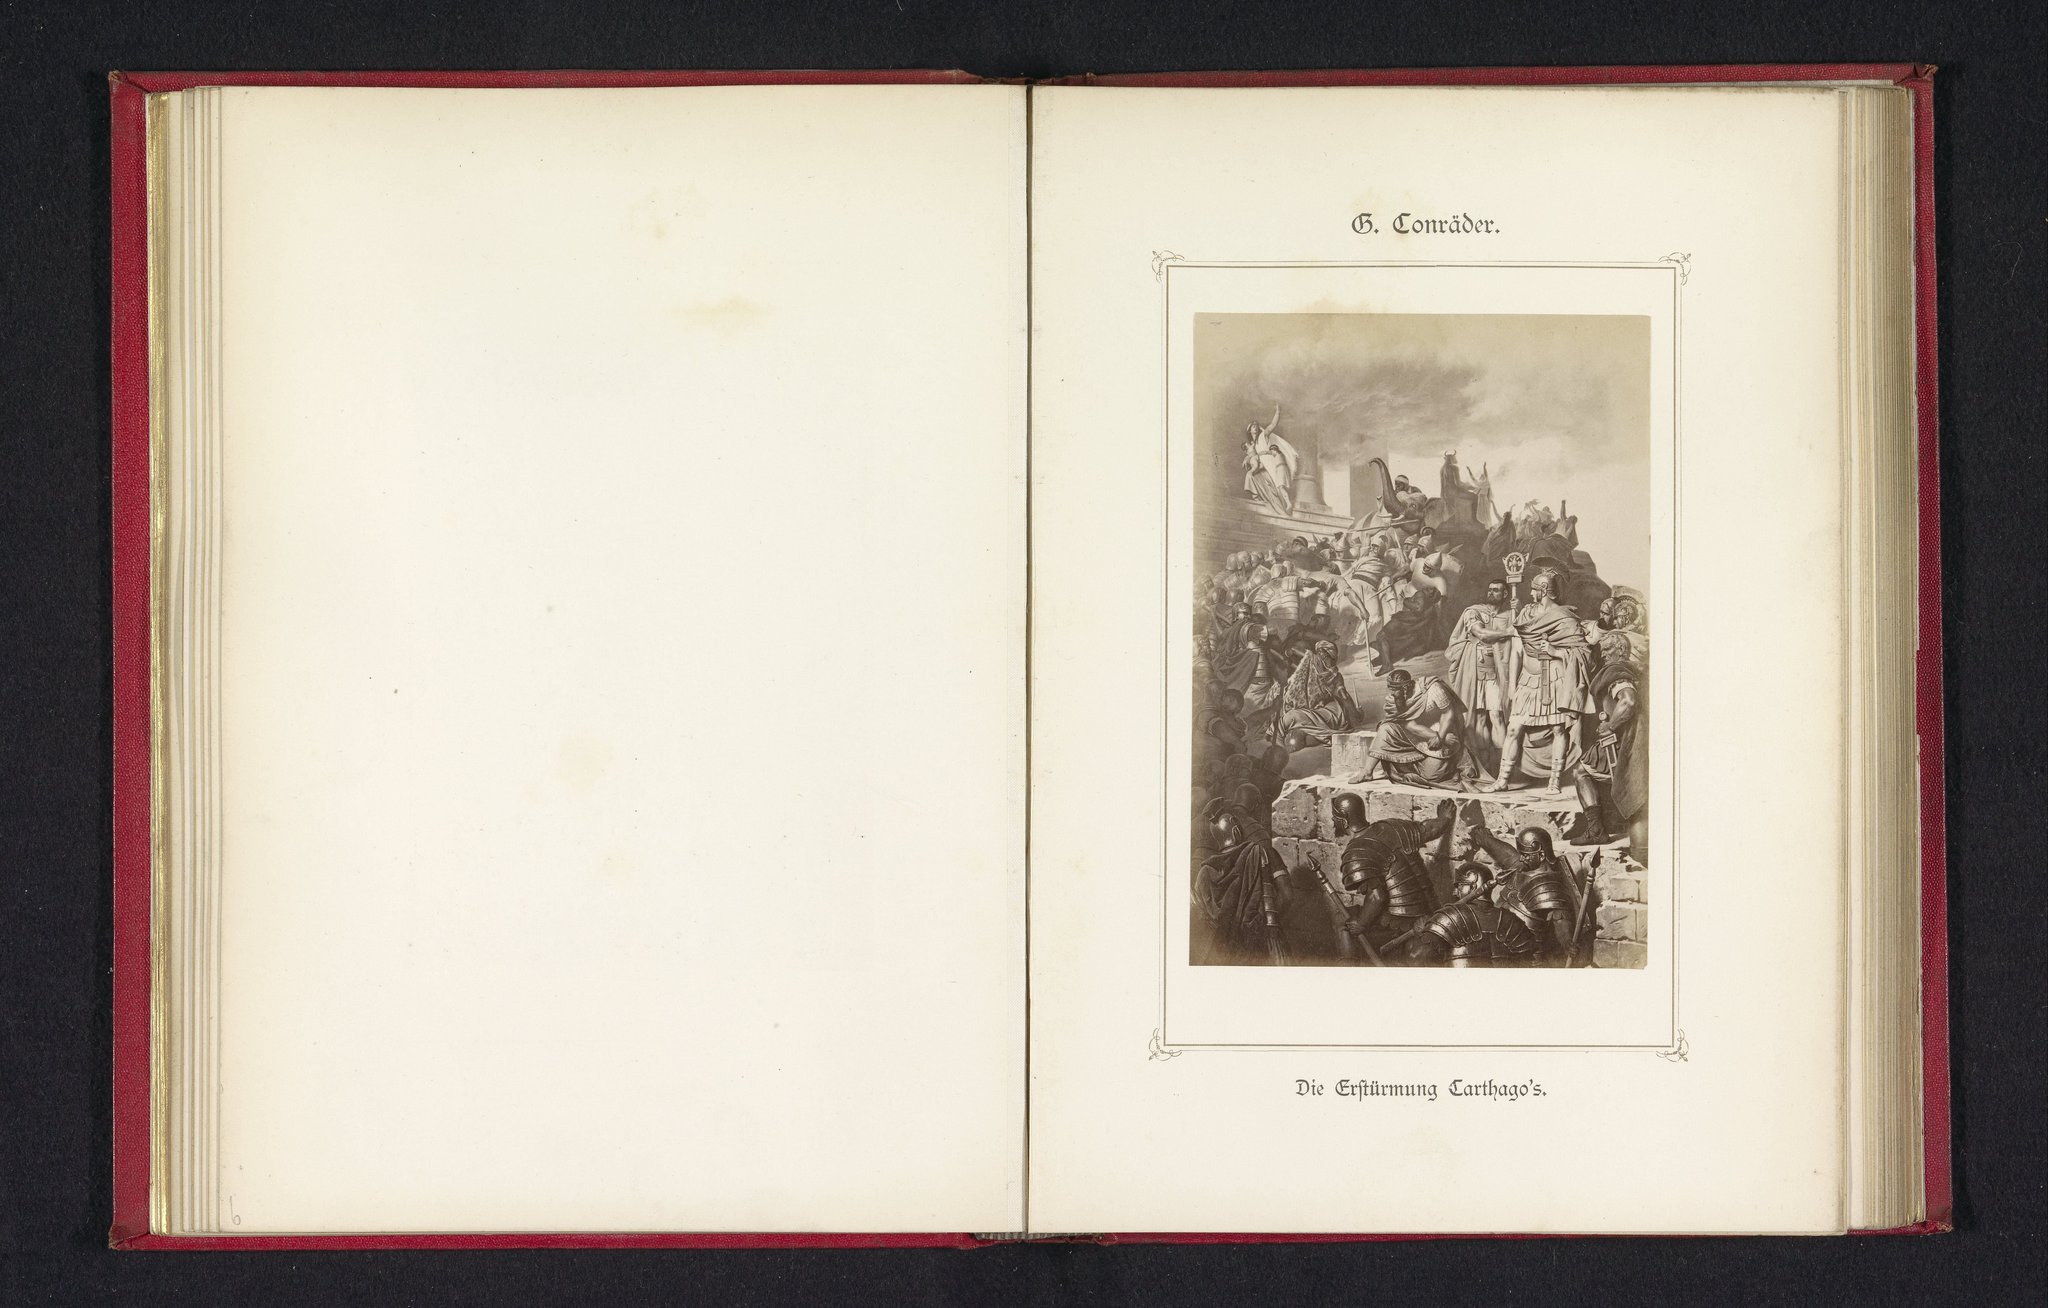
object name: reproduction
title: Fotoreproductie van een schilderij, voorstellende de belegering van Carthago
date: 1875-1880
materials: photographic support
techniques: albumen print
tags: destruction of conquered city